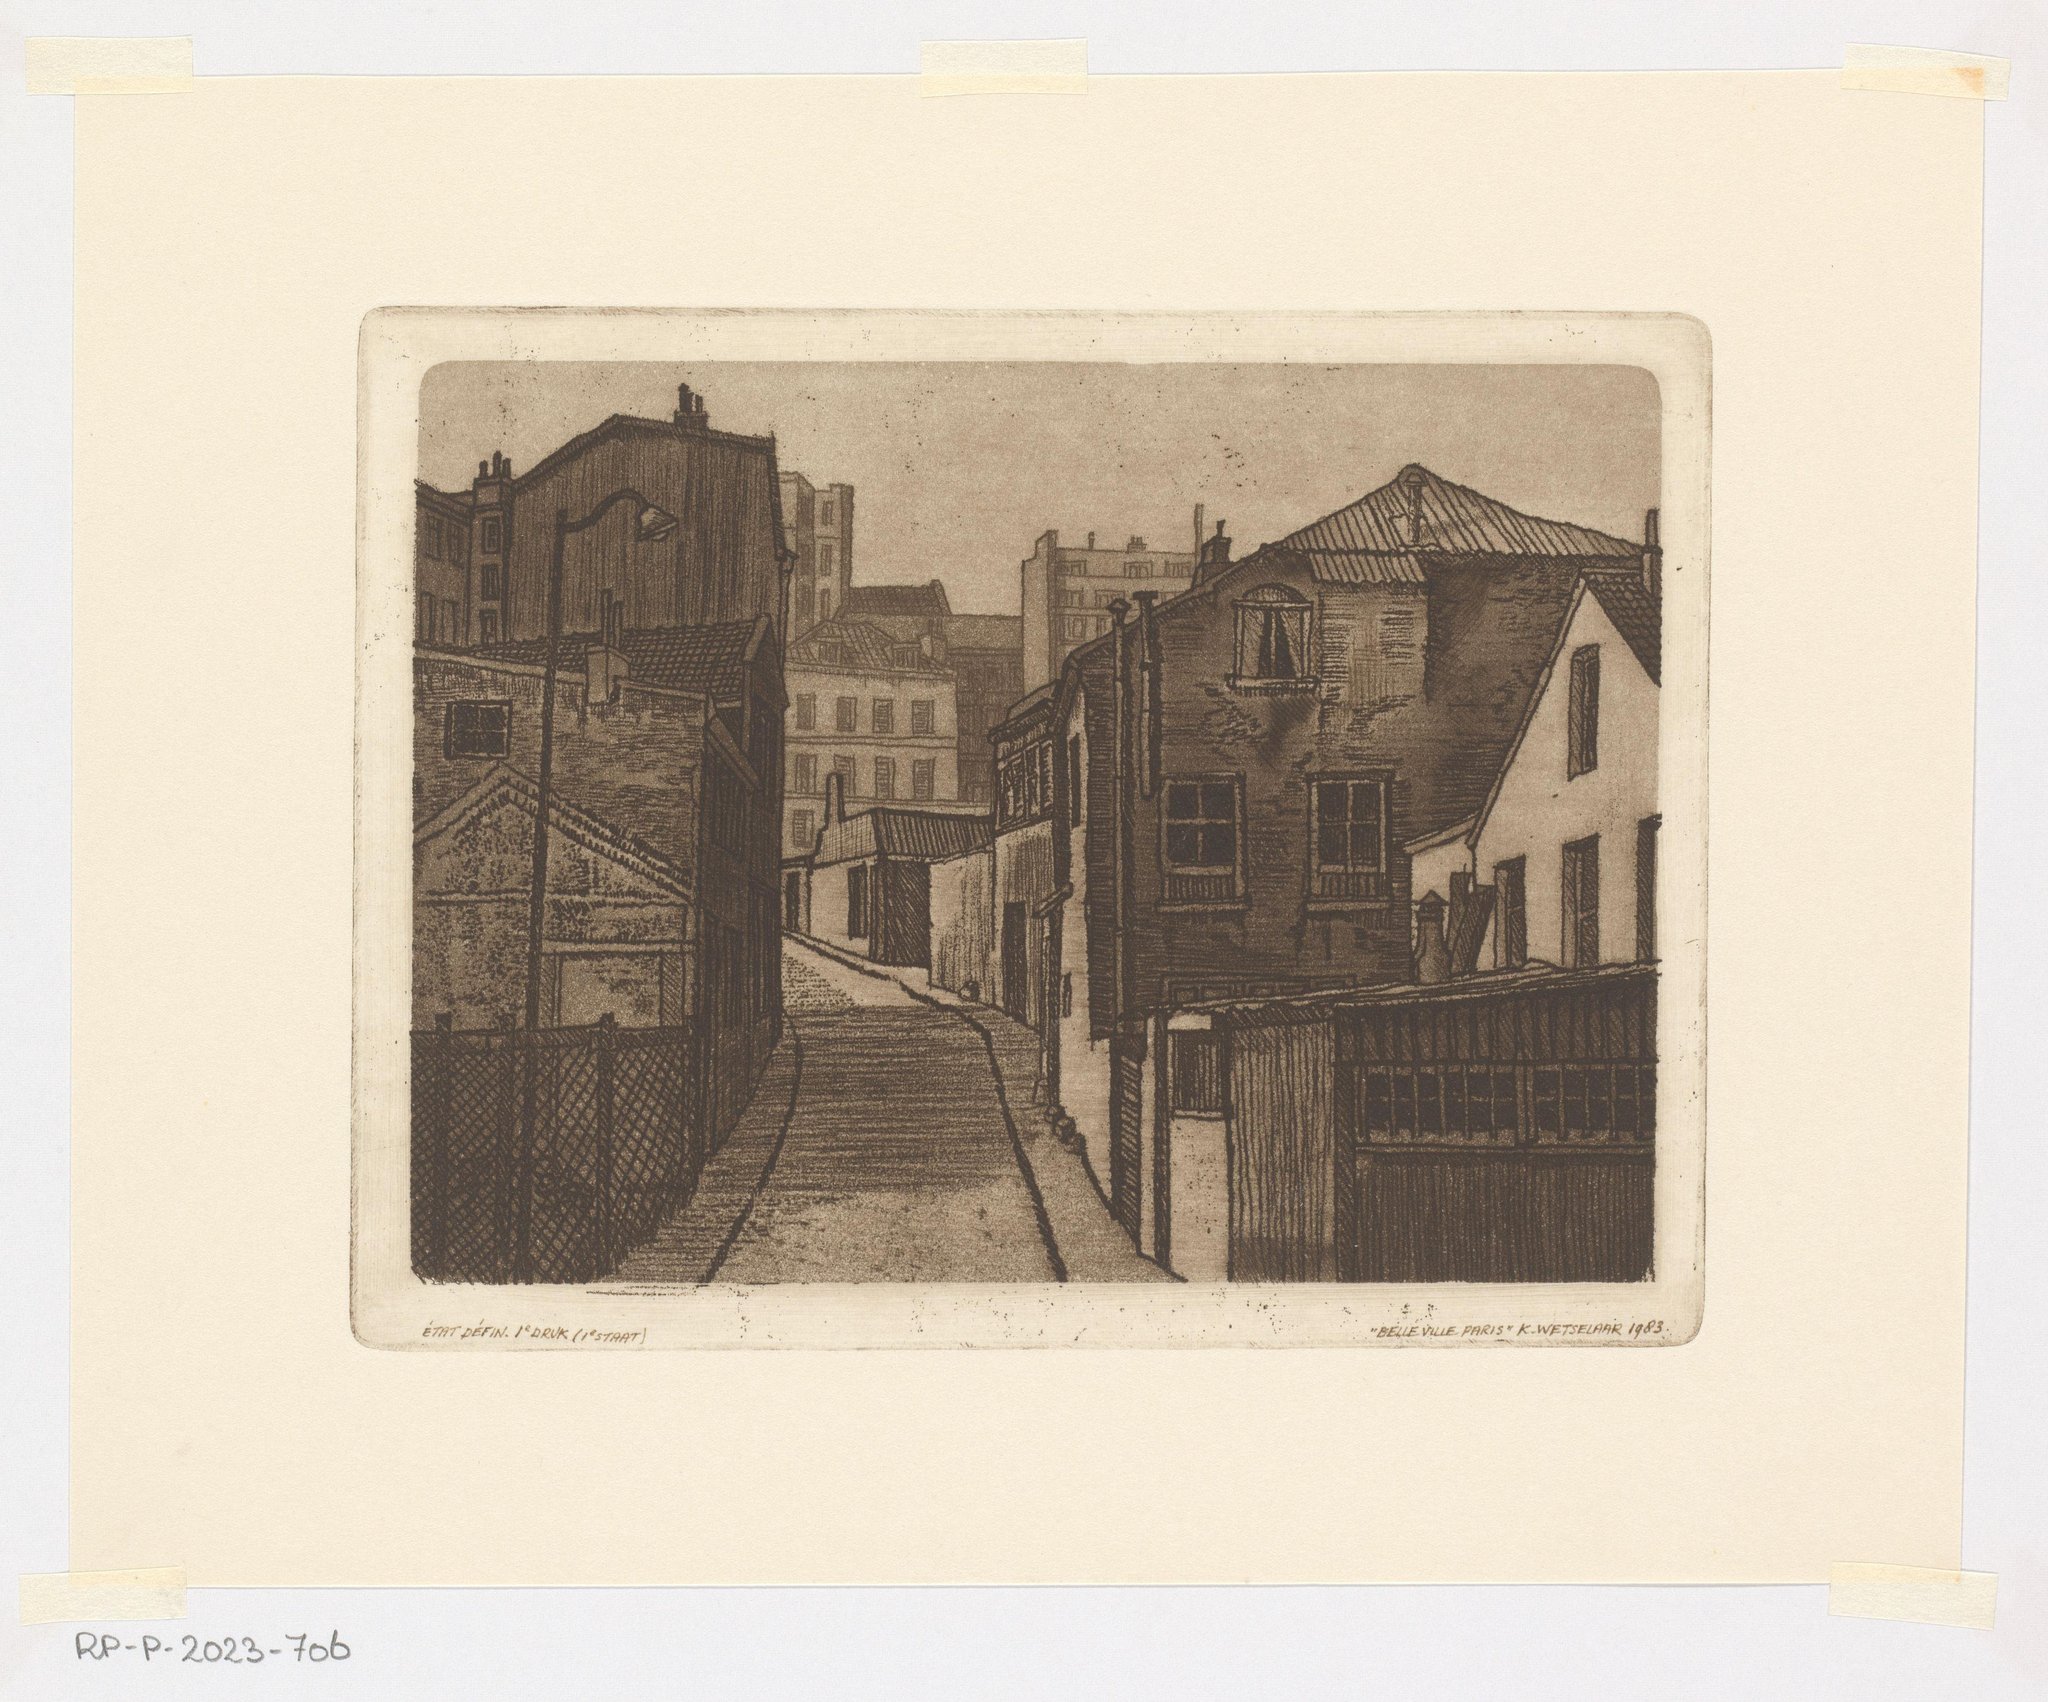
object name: print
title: Belle Ville Paris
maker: karel wetselaar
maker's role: print maker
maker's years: 1935-2017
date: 1983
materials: paper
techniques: aquatint, etching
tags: city-view in general; 'veduta', sloping street; street with steps or stairs, paris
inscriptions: signature and date: ‘K. Wetselaar 1983’, inscription: ‘état défin. 1e druk (1e staat)’